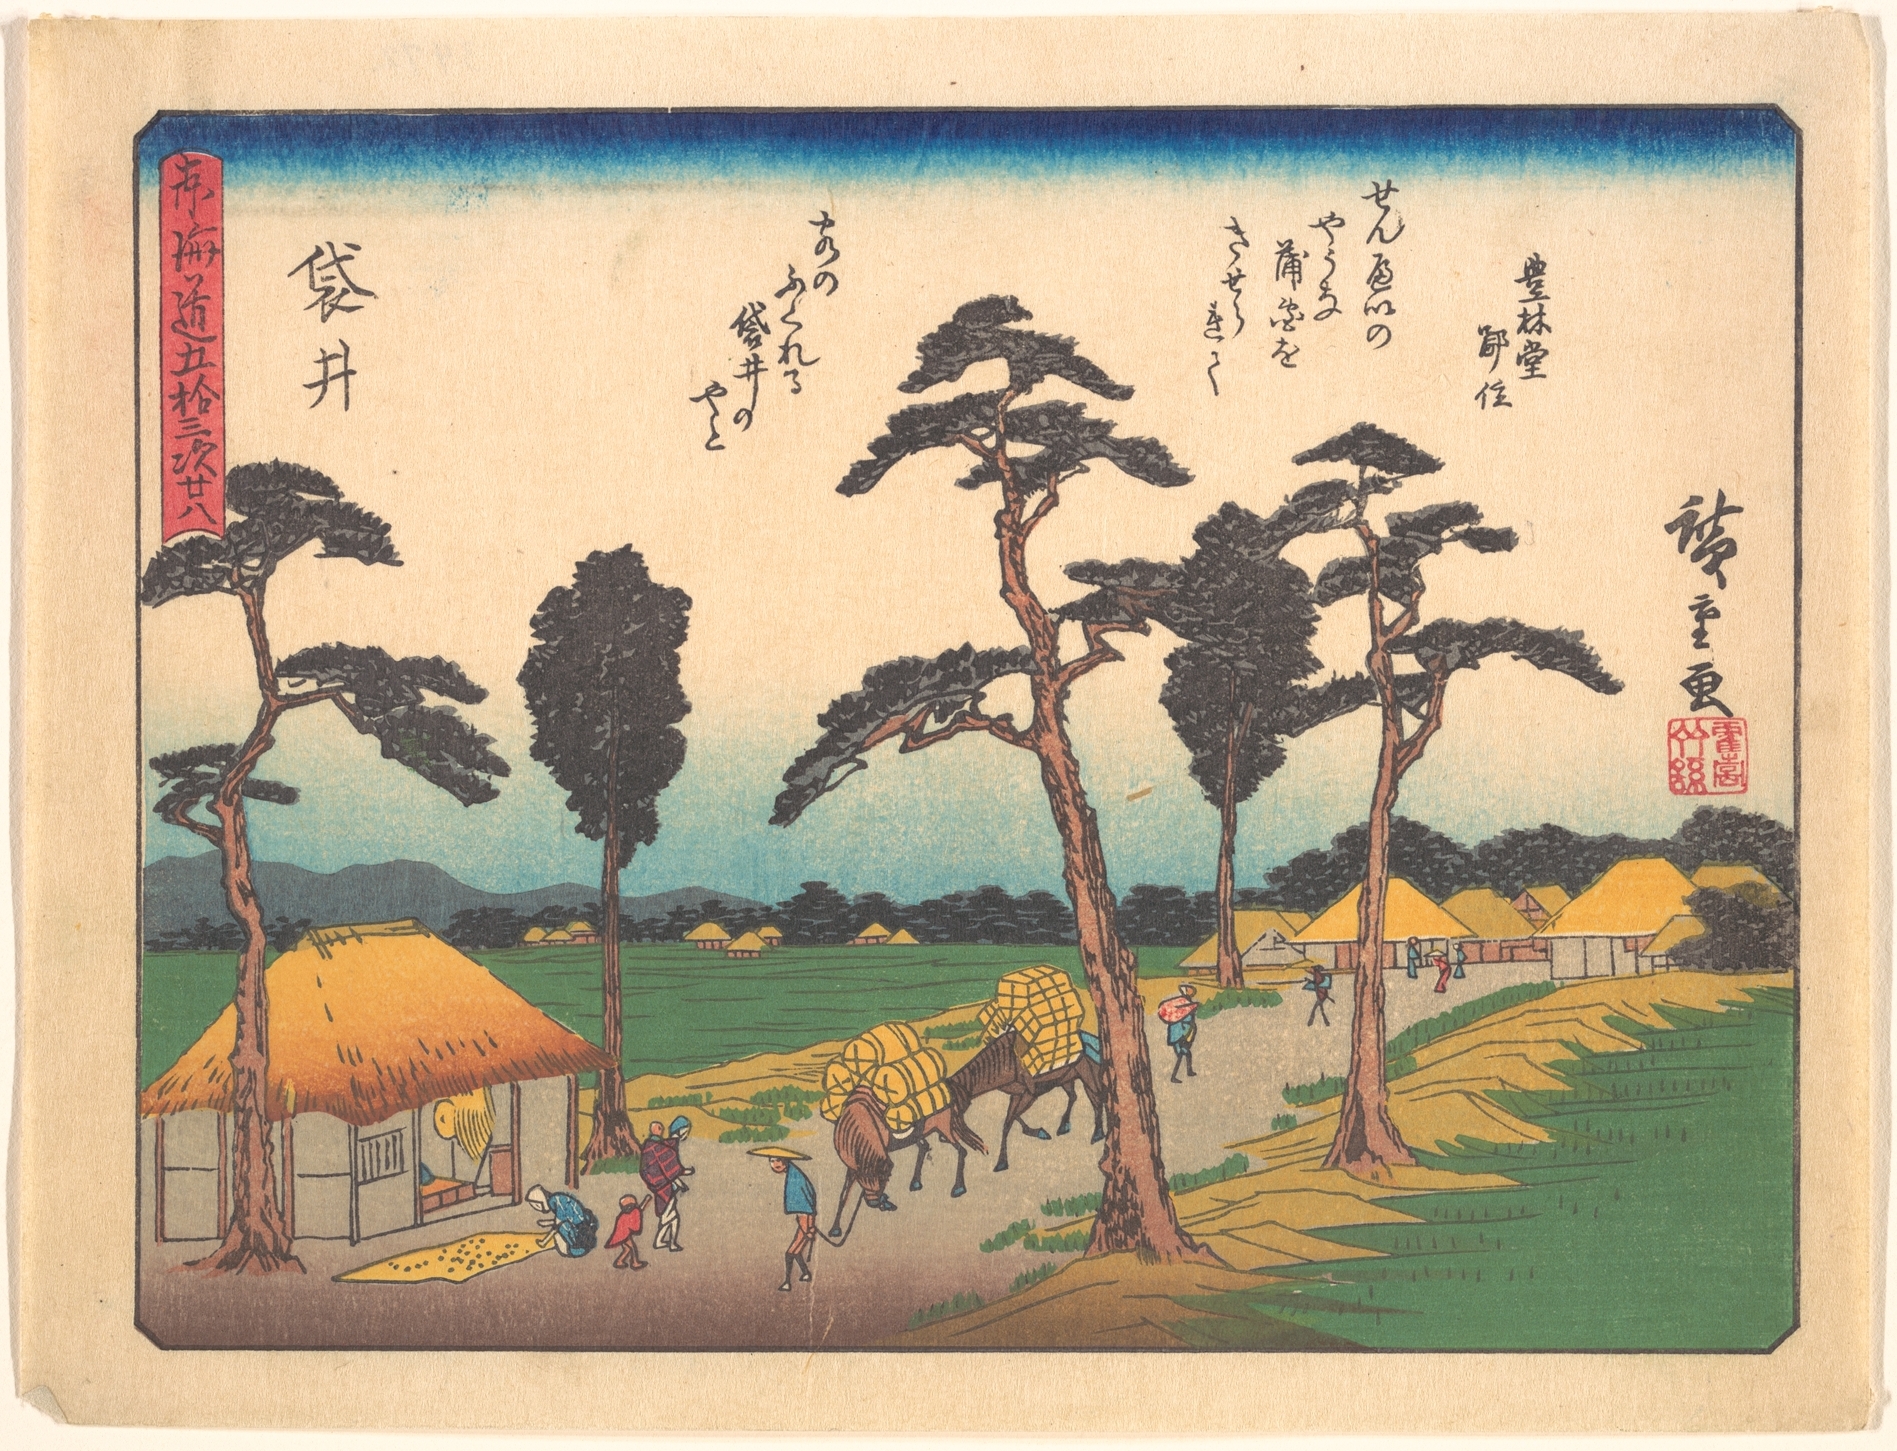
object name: print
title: Fukuroi, from the series The Fifty-three Stations of the Tōkaidō Road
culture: japanese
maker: utagawa hiroshige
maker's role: artist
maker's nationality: japanese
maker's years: 1797-1858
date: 1901-1933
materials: ink, paper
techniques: woodblock print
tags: houses,horses,landscapes,trees,working